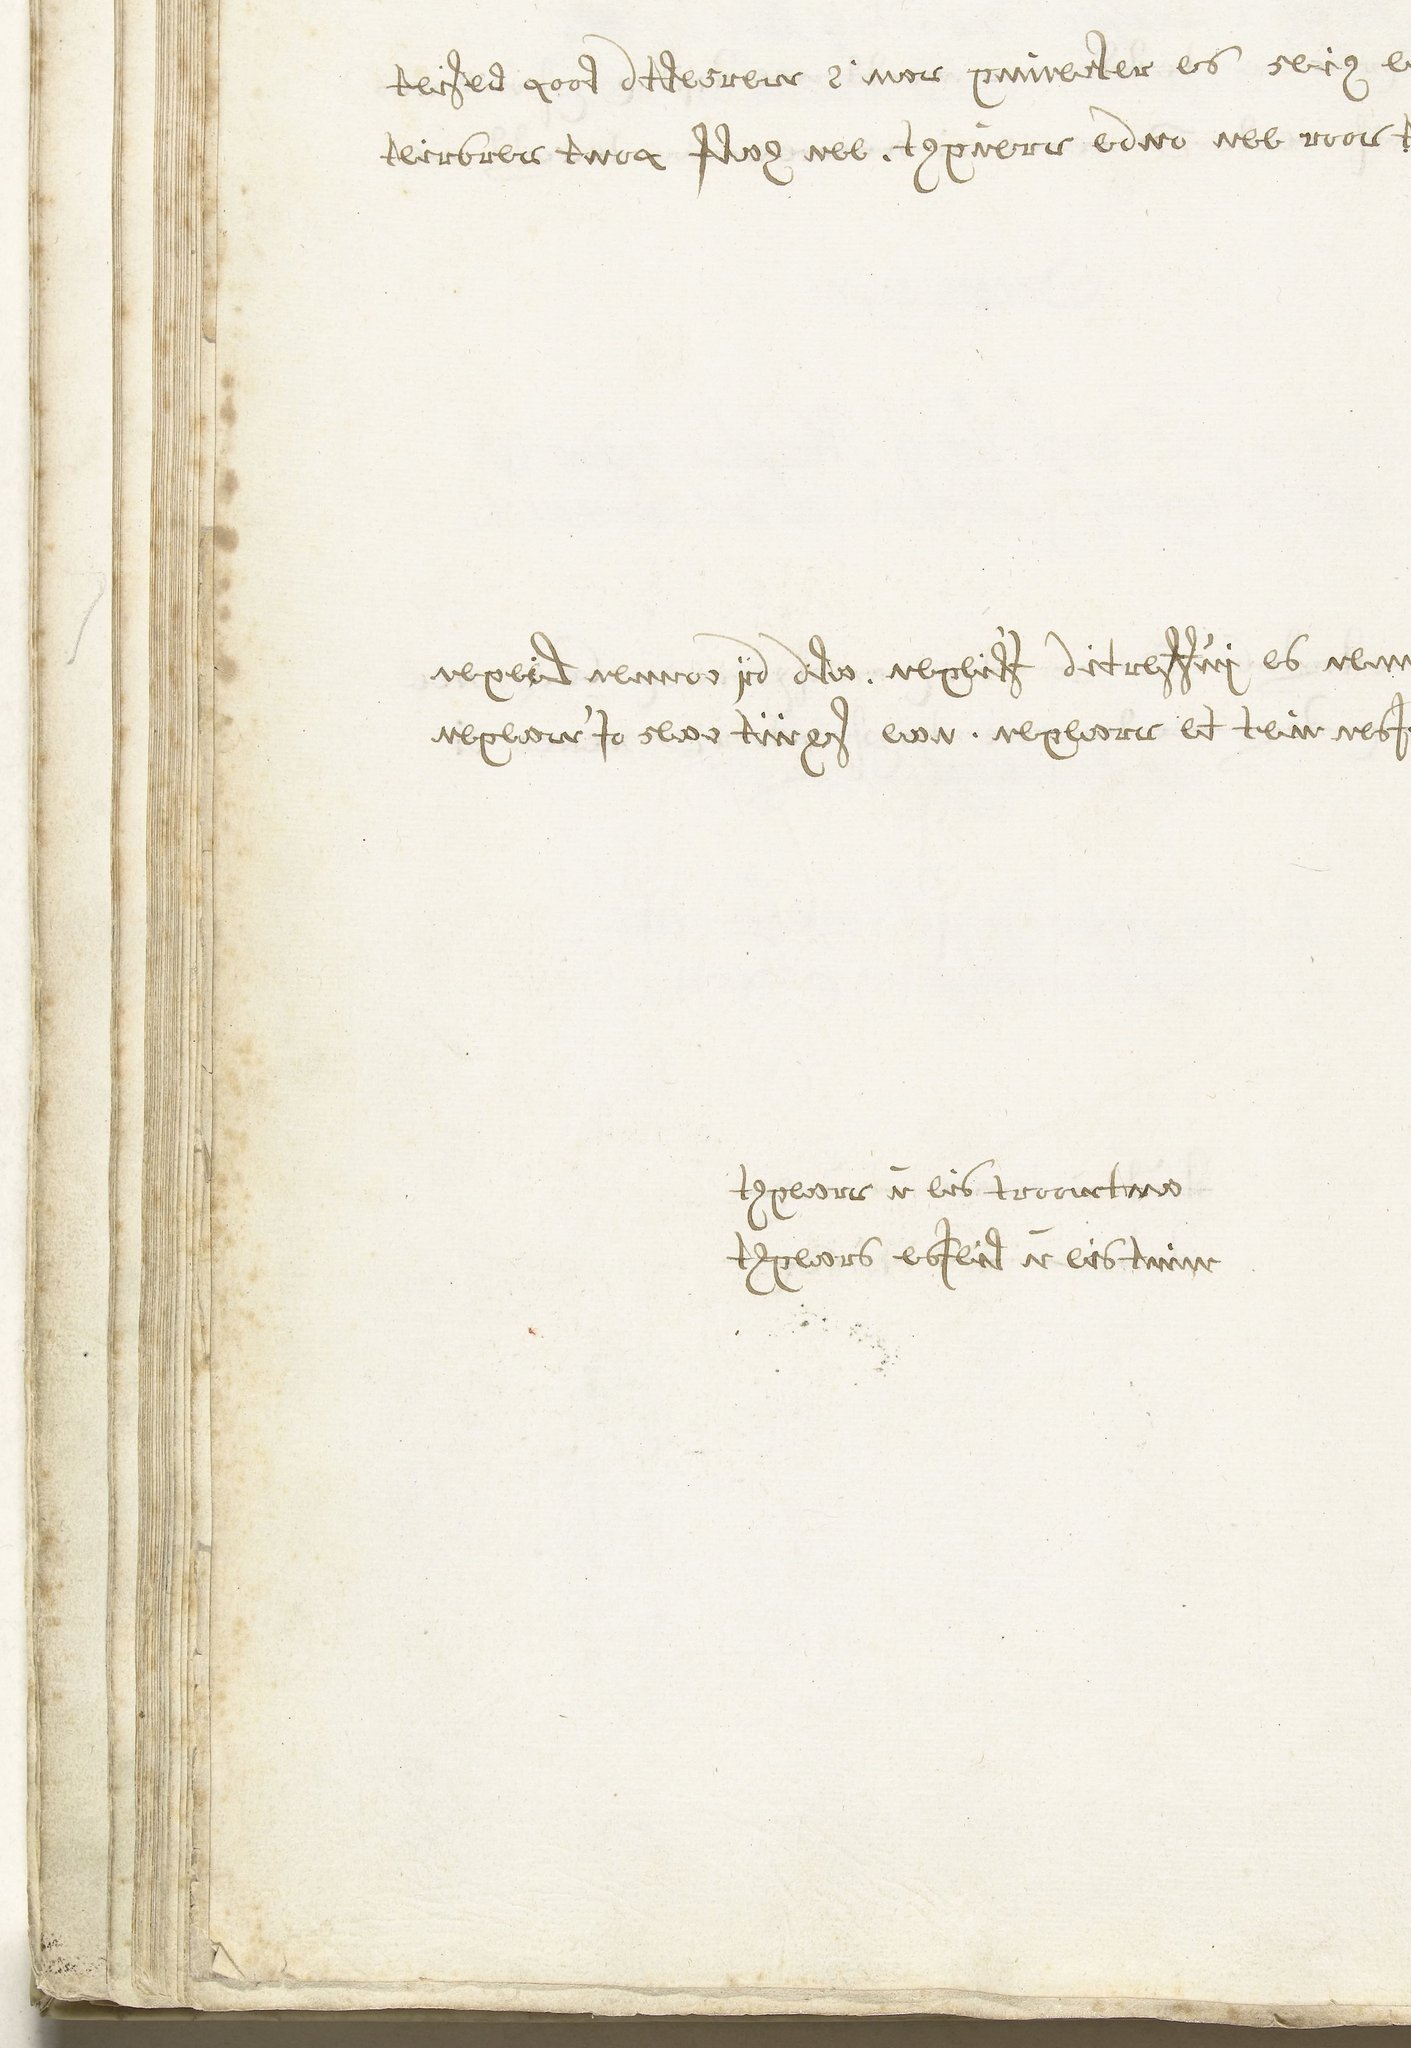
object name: calligraphy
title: Eigentijdse Nederlandse aforismen in spiegelbeeld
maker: henrik jordis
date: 1652-1680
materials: ink, paper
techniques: calligraphy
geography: zwolle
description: Het blad is later aan het Album toegevoegd en genummerd toen het opnieuw ingebonden werd. De middelste tekst is een herhaling van folio 8 van het Poëzie-album, met als verandering dat jonghmans vervangen is door juffertis. De derde tekst komt uit Spiegel van den ouden ende nieuwen tijdt (I, p. 33) van Jacob Cats.